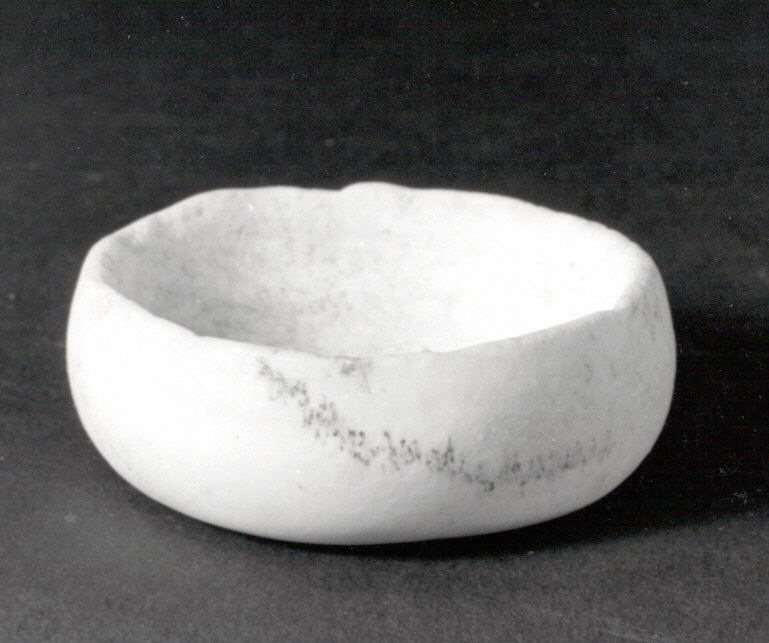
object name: bowl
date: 7000-5001 BCE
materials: alabaster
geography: syria